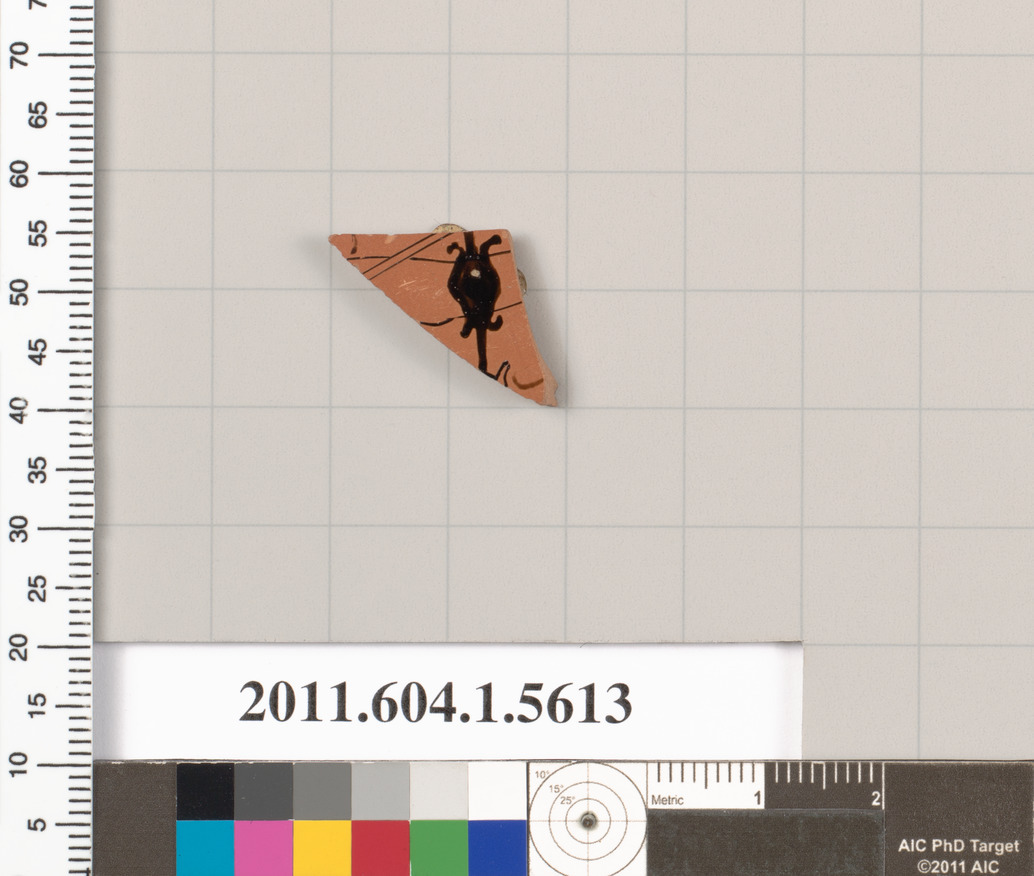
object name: kylix fragment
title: Terracotta fragment of a kylix (drinking cup)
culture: greek, attic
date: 510-490 BCE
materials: terracotta